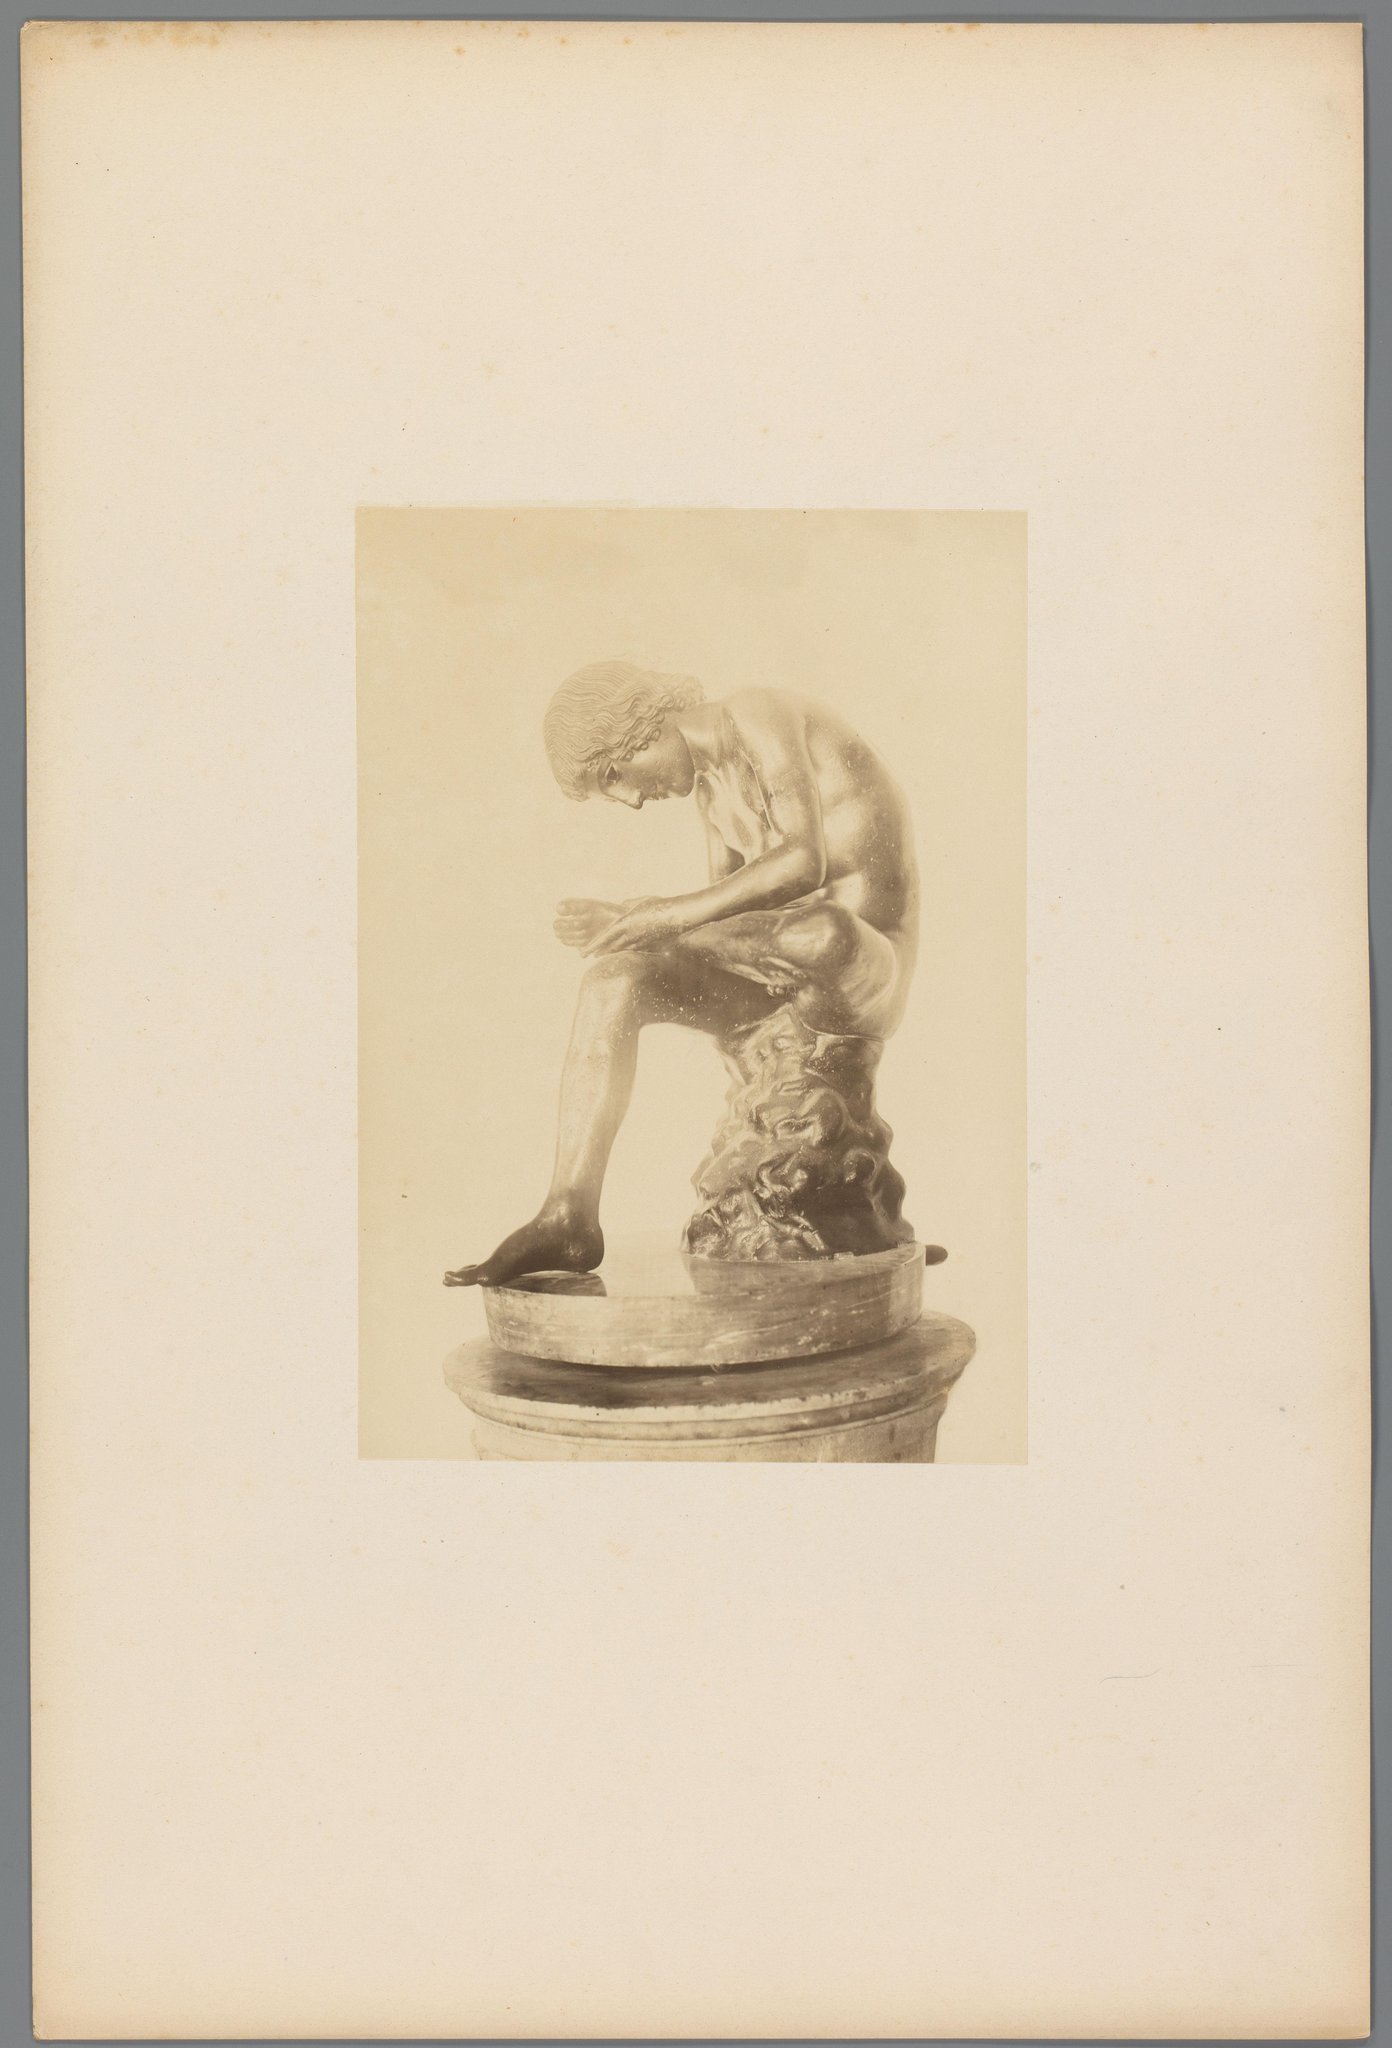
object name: photograph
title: Sculptuur van een figuur kijkend onder zijn voetzolen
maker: Anonymous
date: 1851-1900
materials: cardboard, paper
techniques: albumen print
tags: piece of sculpture, reproduction of a piece of sculpture